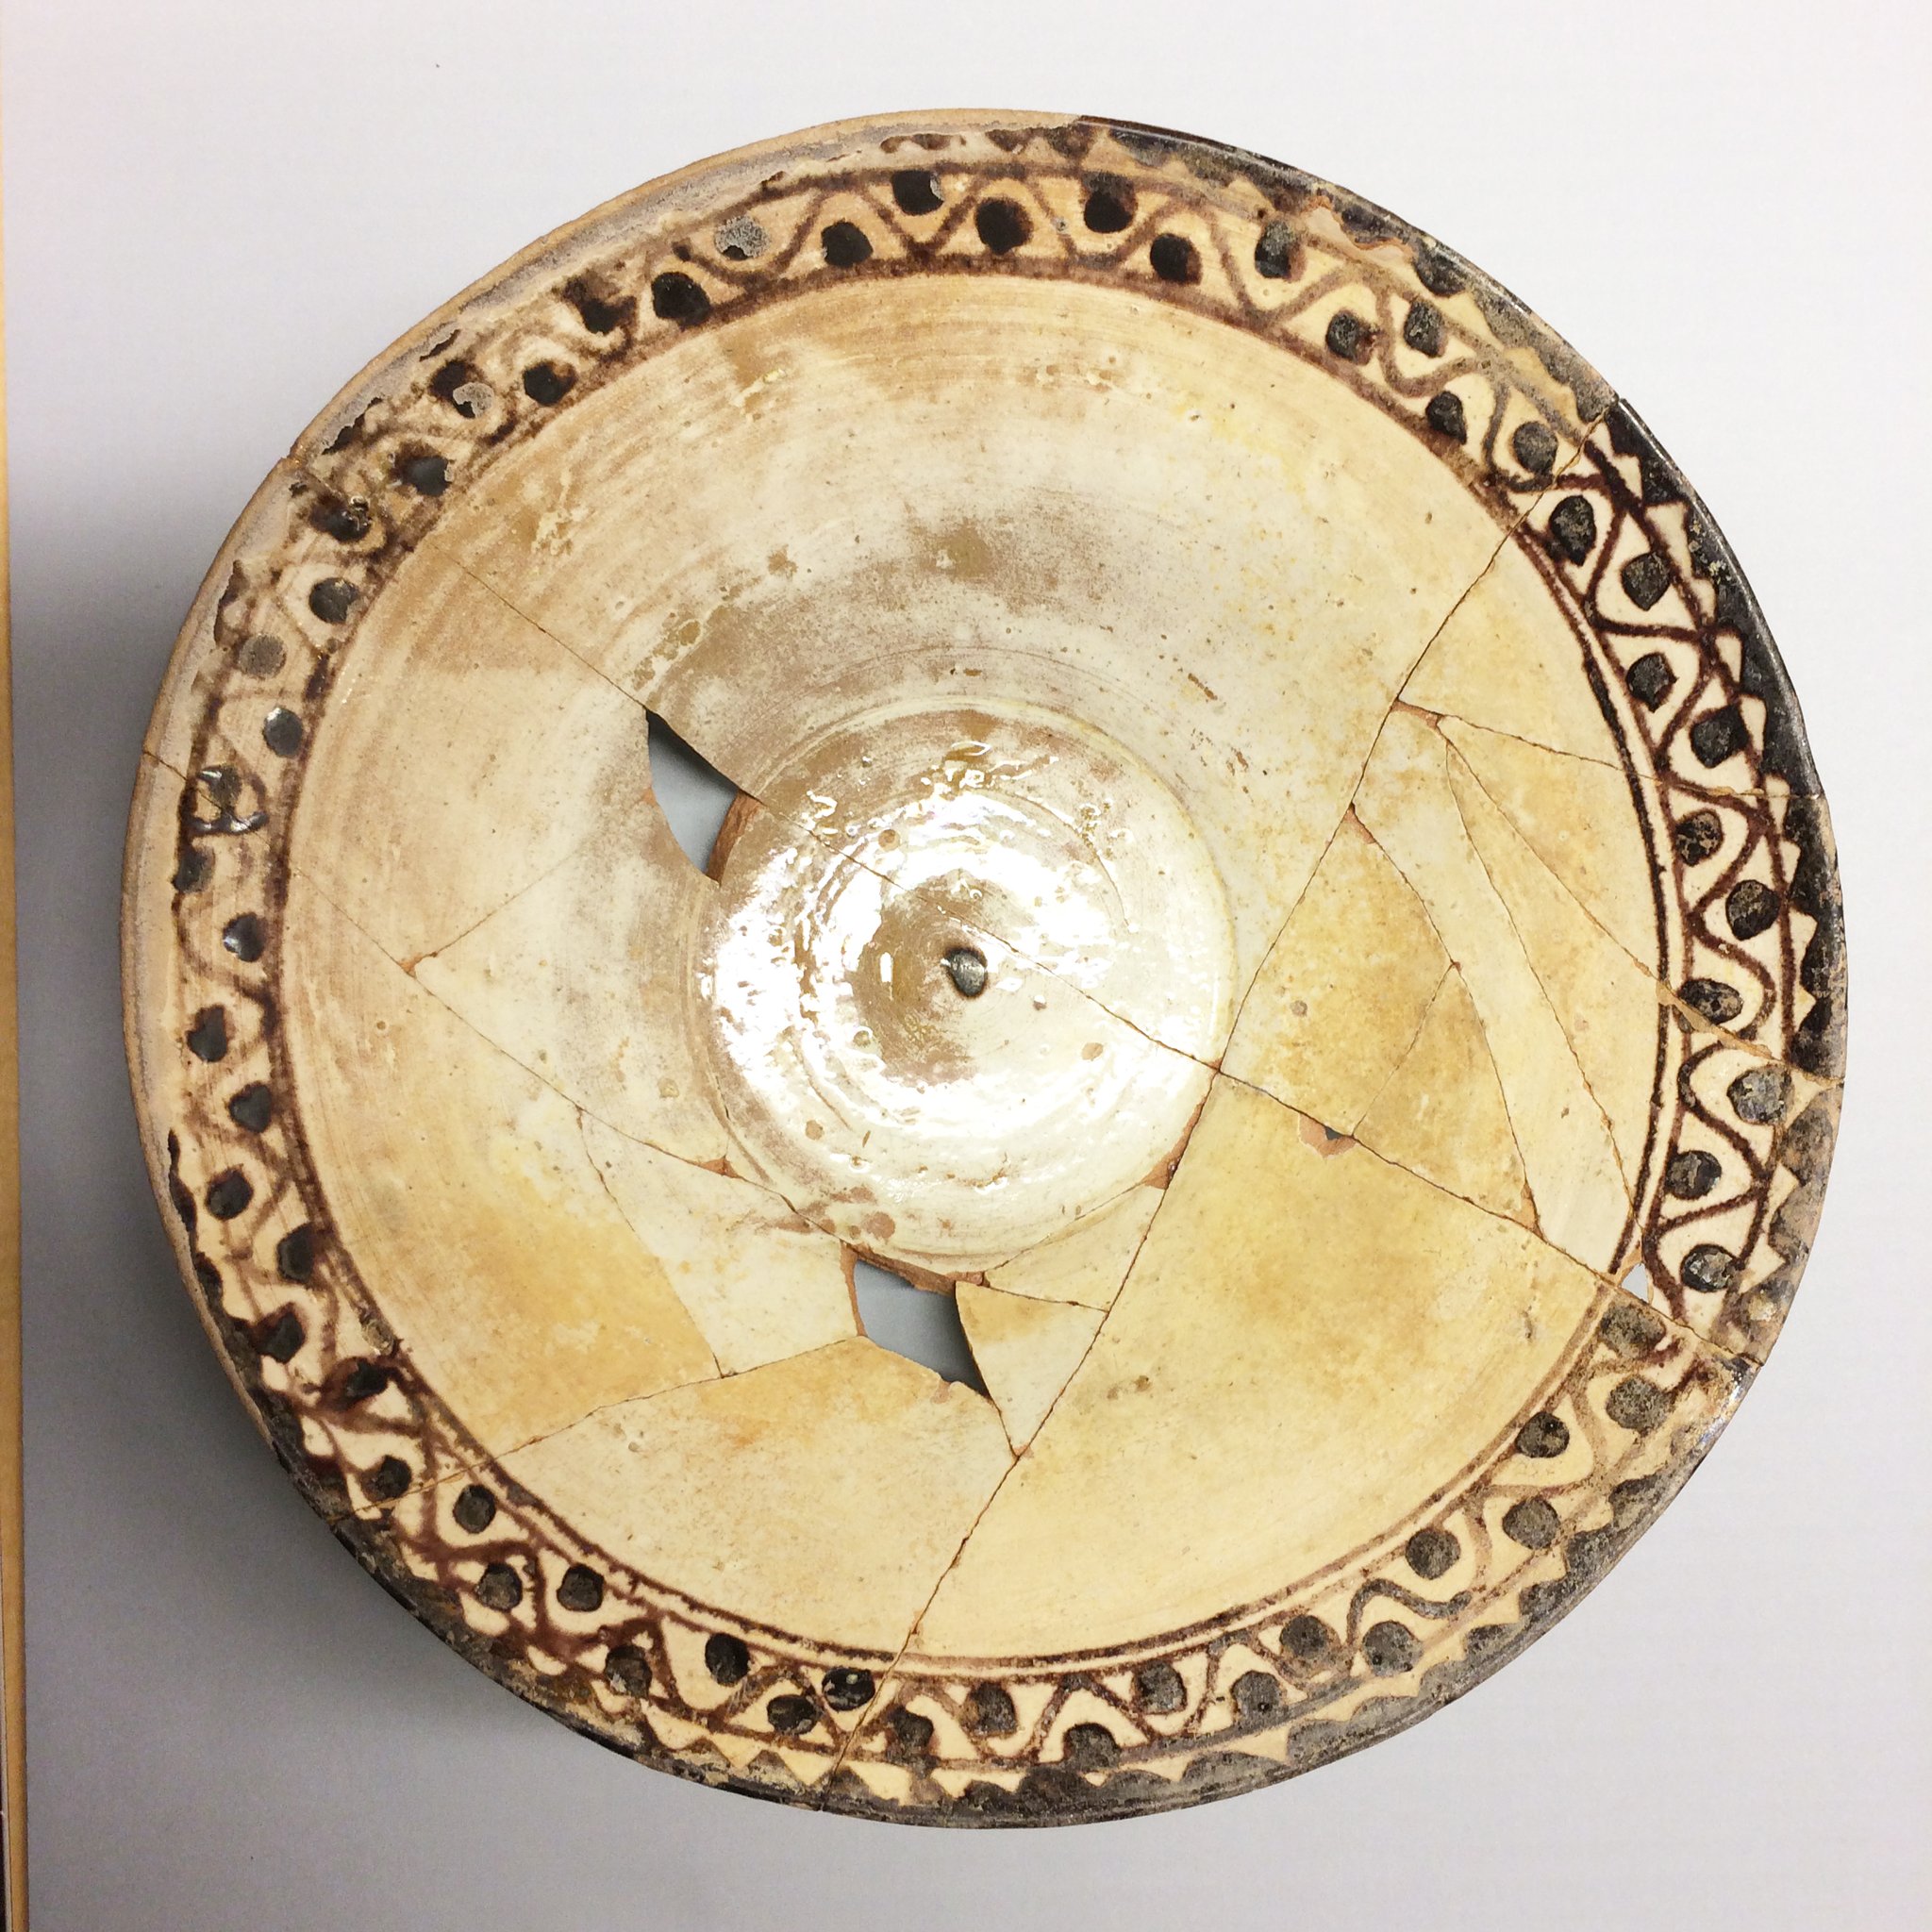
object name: bowl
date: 801-900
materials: earthenware, glaze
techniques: polychrome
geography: iran